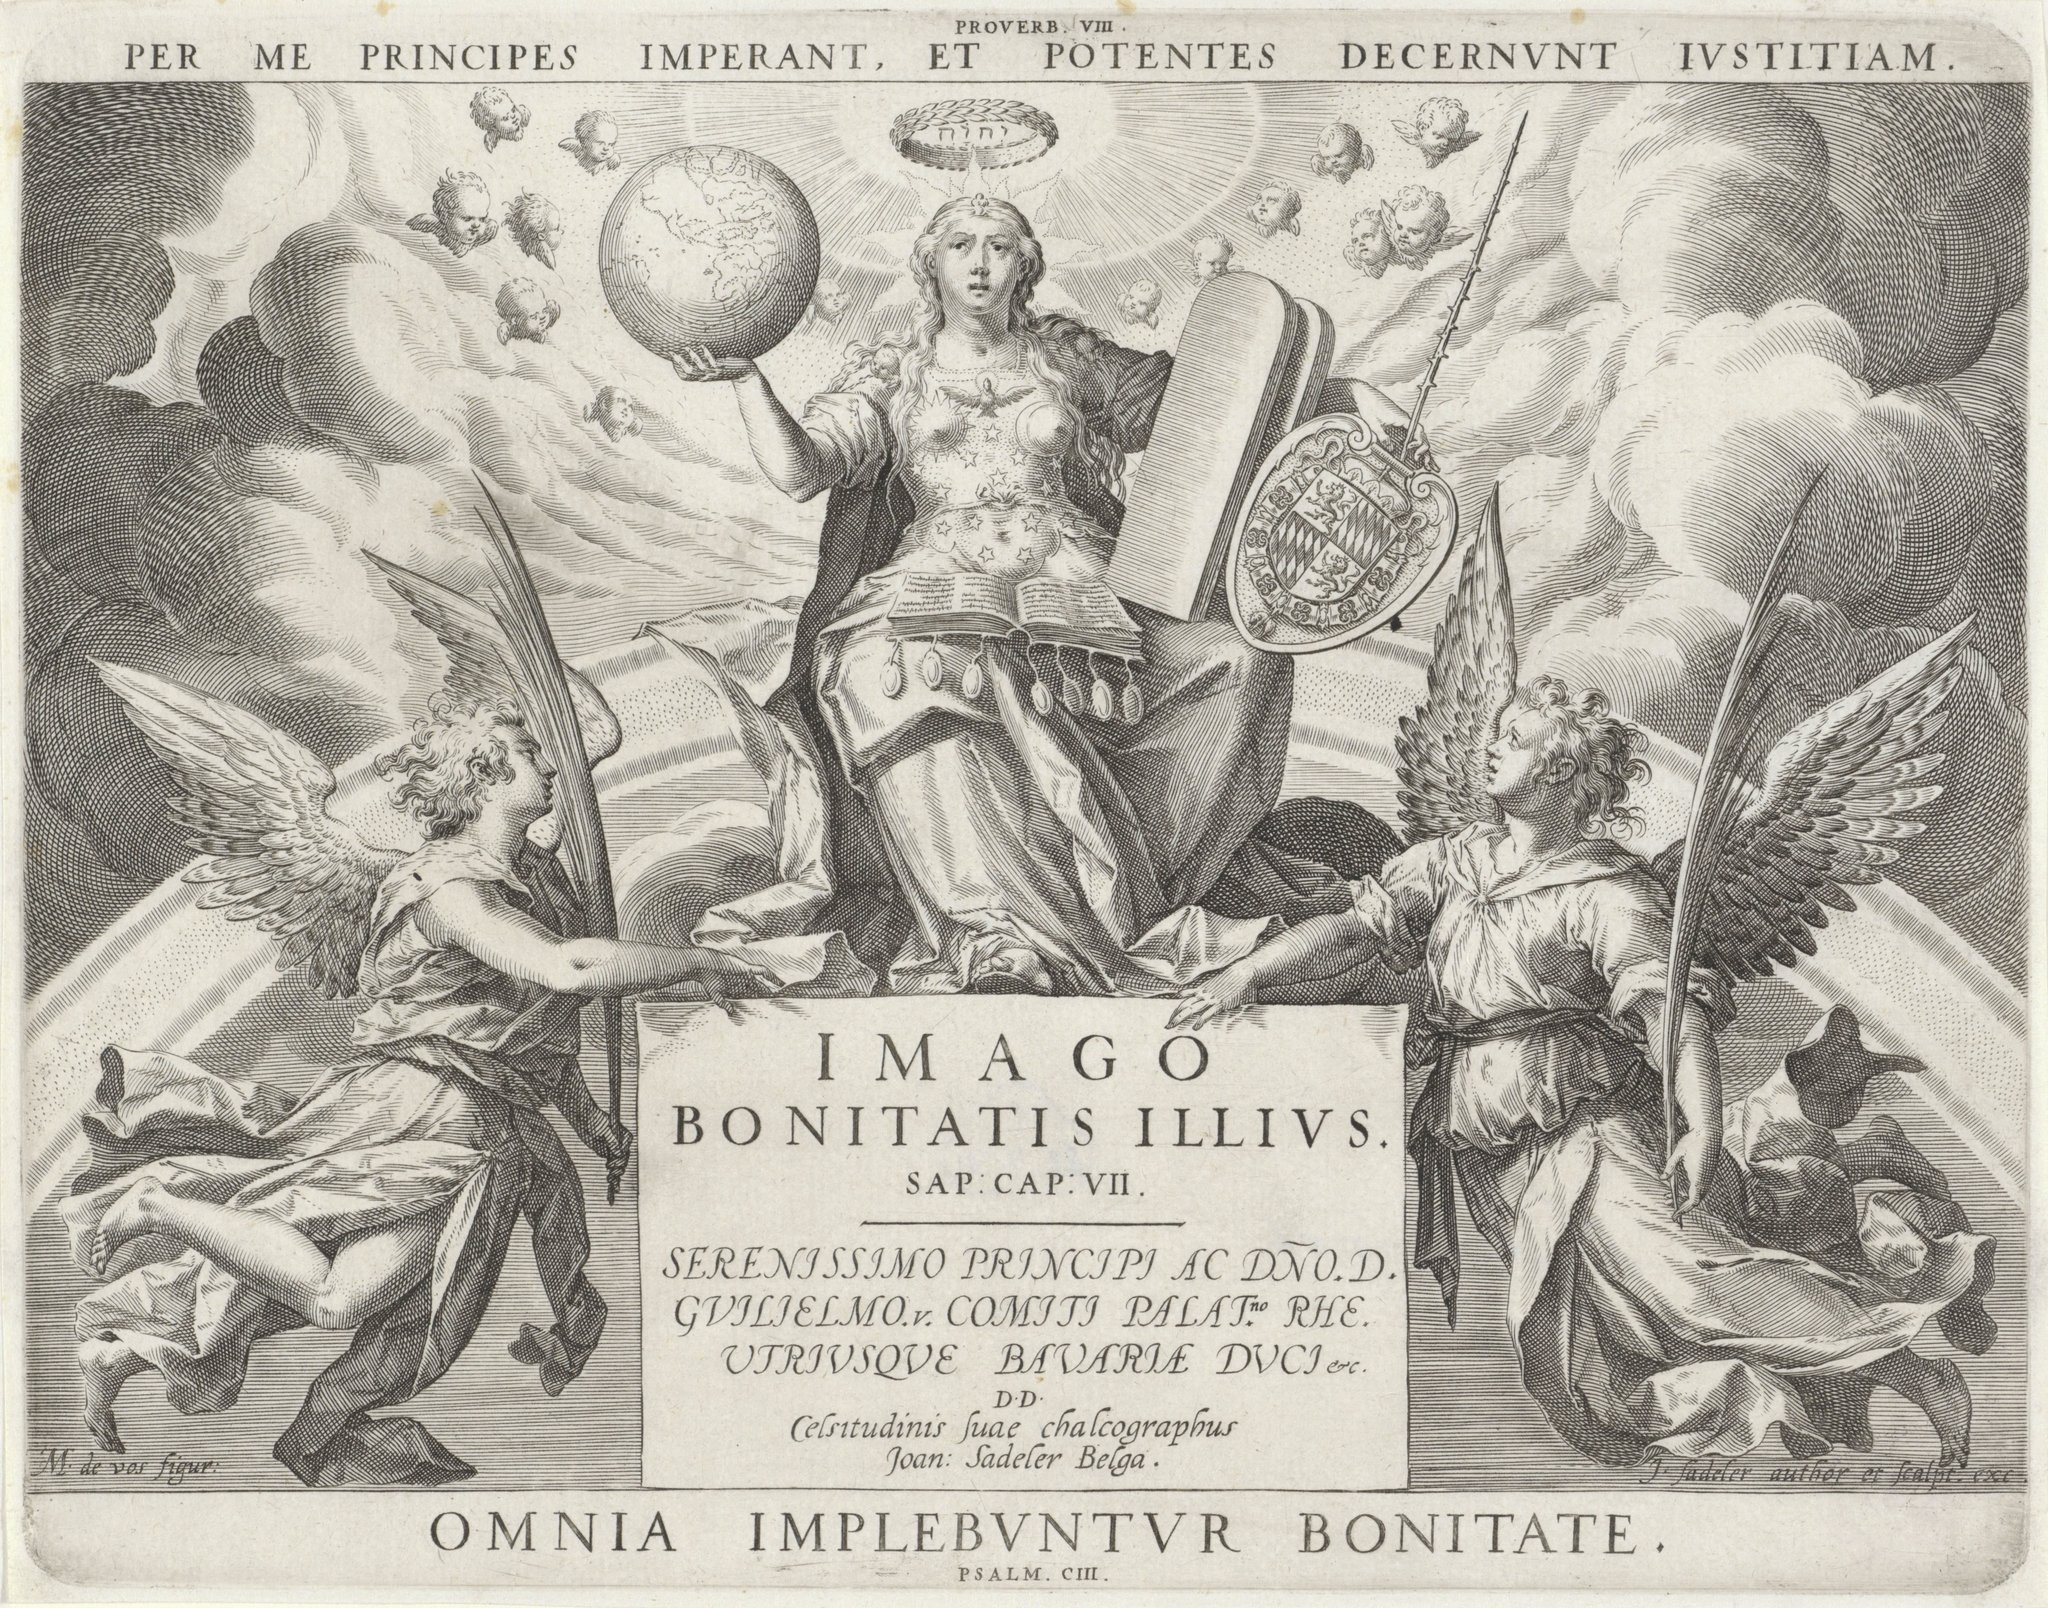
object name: titelprent, frontispice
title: Geloof tronend in de hemel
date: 1588-1600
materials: paper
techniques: engraving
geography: munich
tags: cherubs, i.e. children's heads with wings, faith, 'fides'; 'fede', 'fede catholica', 'fede christiana', 'fede christiana catholica' (ripa) ~ one of the three theological virtues, title-page, the ten commandments represented together on stone tablets, angels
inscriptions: collector's mark: Lugt 240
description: De personificatie van het christelijk geloof met in haar handen de wereldbol, de tafelen der wet en een schild. Boven haar hoofd het tetragram van God. Geloof zit op een regenboog in de hemel en wordt geflankeerd door twee engelen. Rondom haar cherubijnen in de wolken.